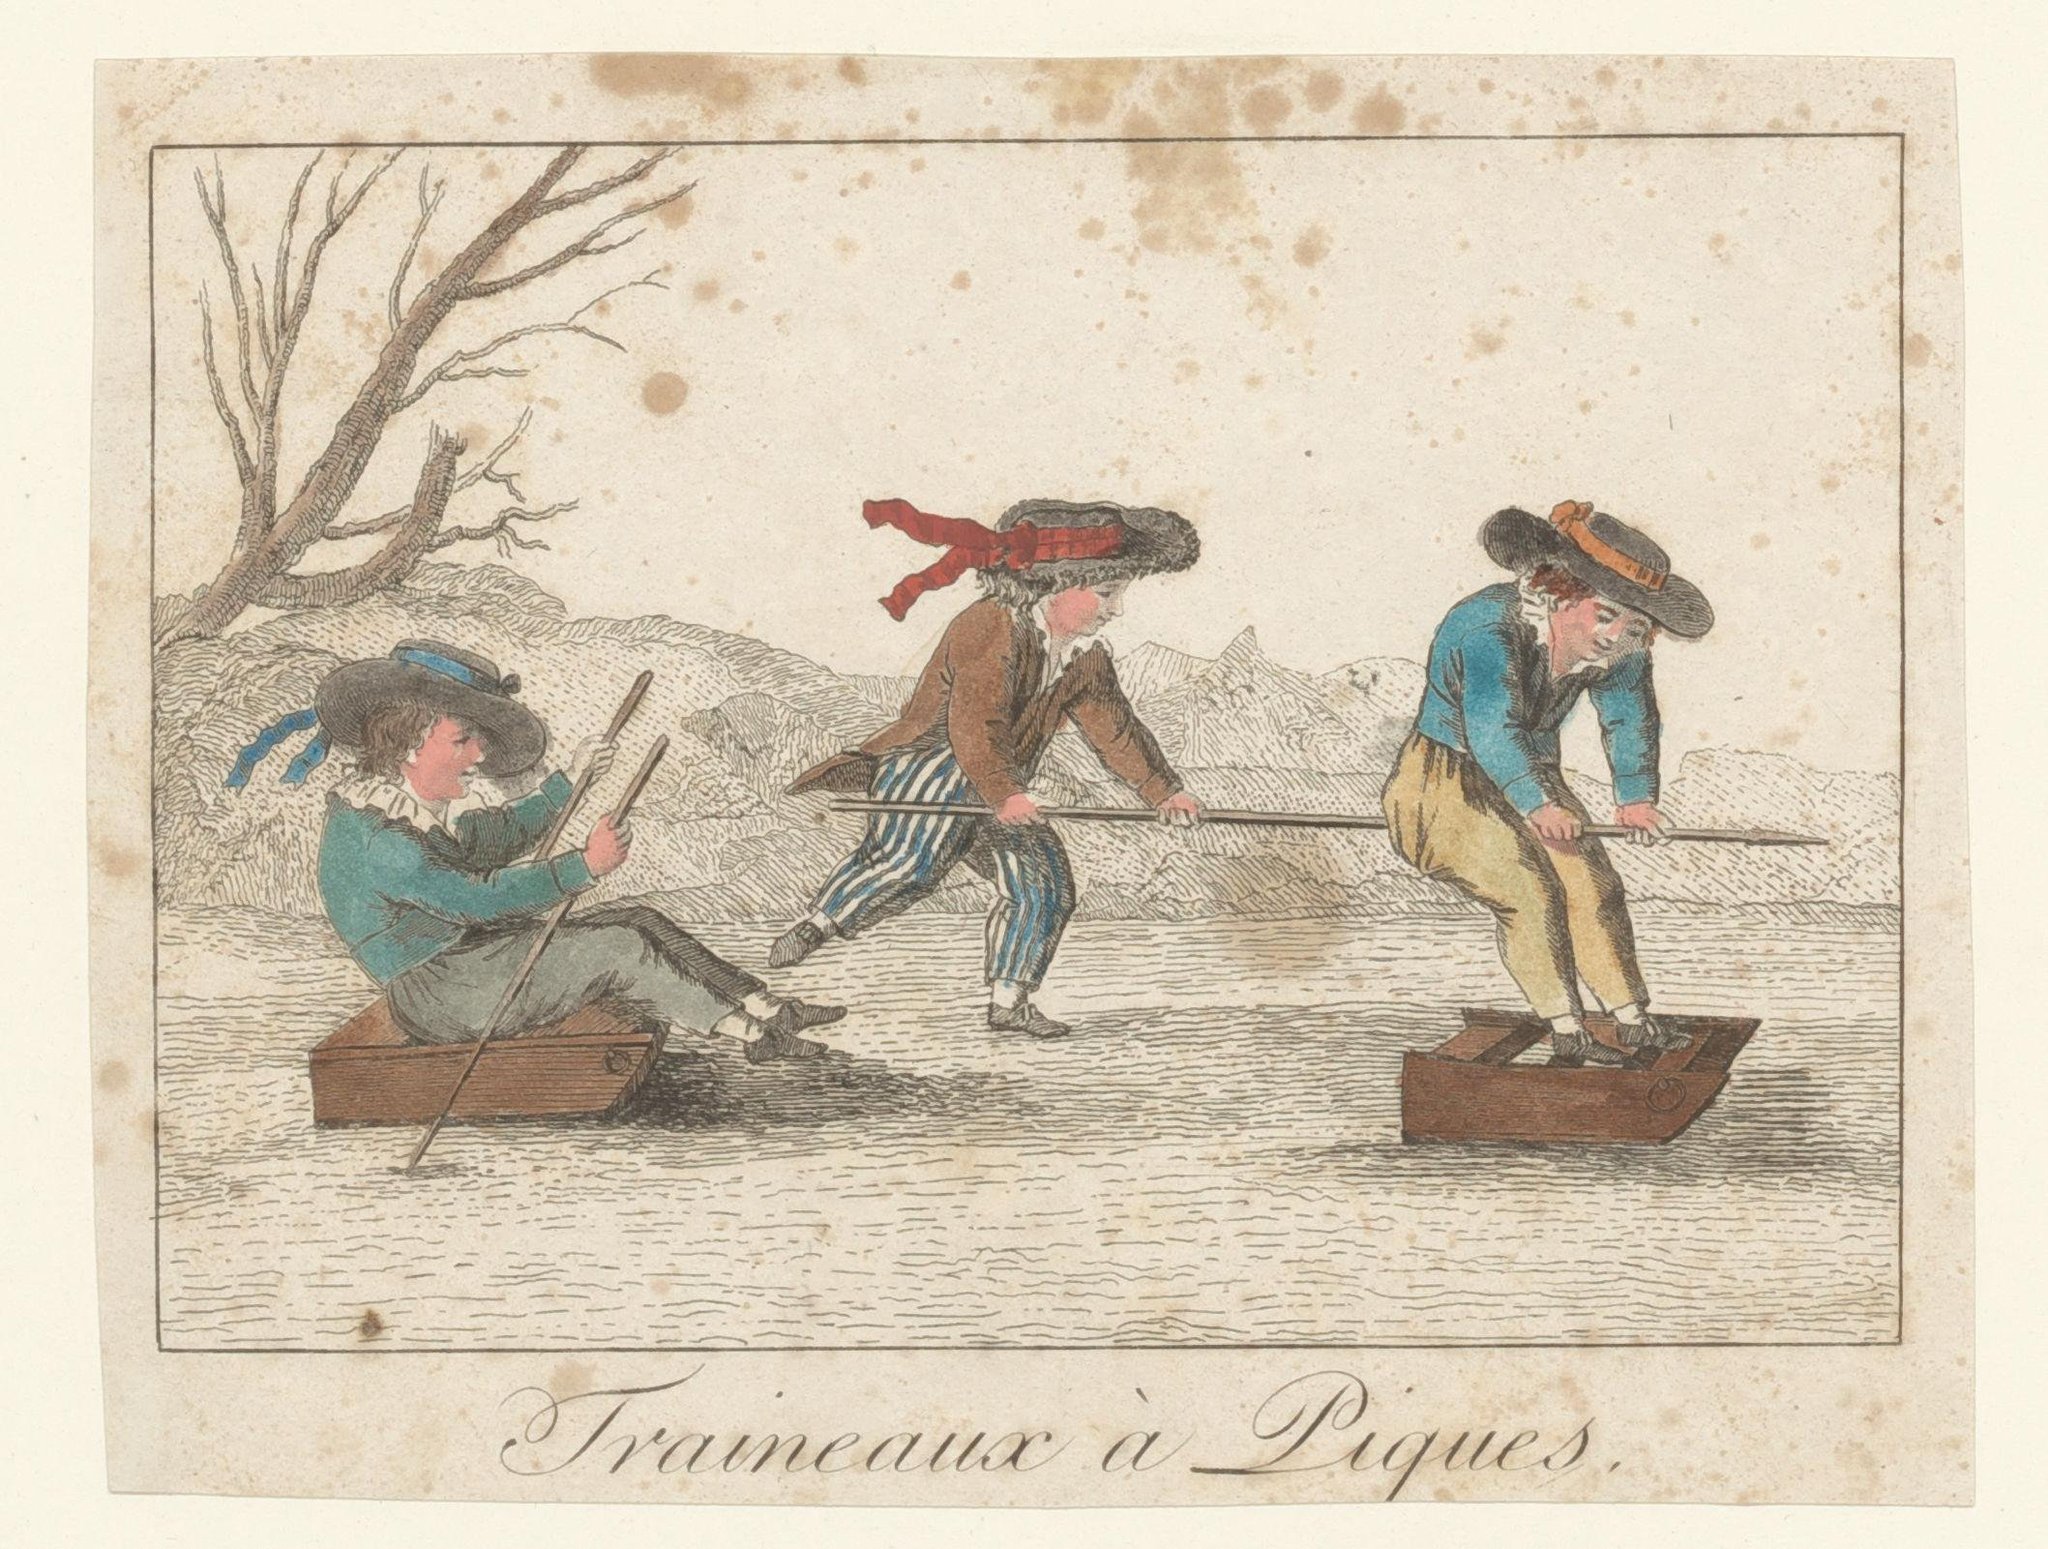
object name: print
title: Sleeënde kinderen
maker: Anonymous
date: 1800-1899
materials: paper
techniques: etching, hand coloring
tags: children's games and plays, throwing games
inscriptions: collector's mark: Lugt 1641, stamp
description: Onderwerpsrubrieken binnen de Atlas Zeden en Gewoonten: Zeden en Gewoonten in Engeren Zin, Des menschen beging, midden en einde, Kinderleven – Kinderspel en Kinderprenten.